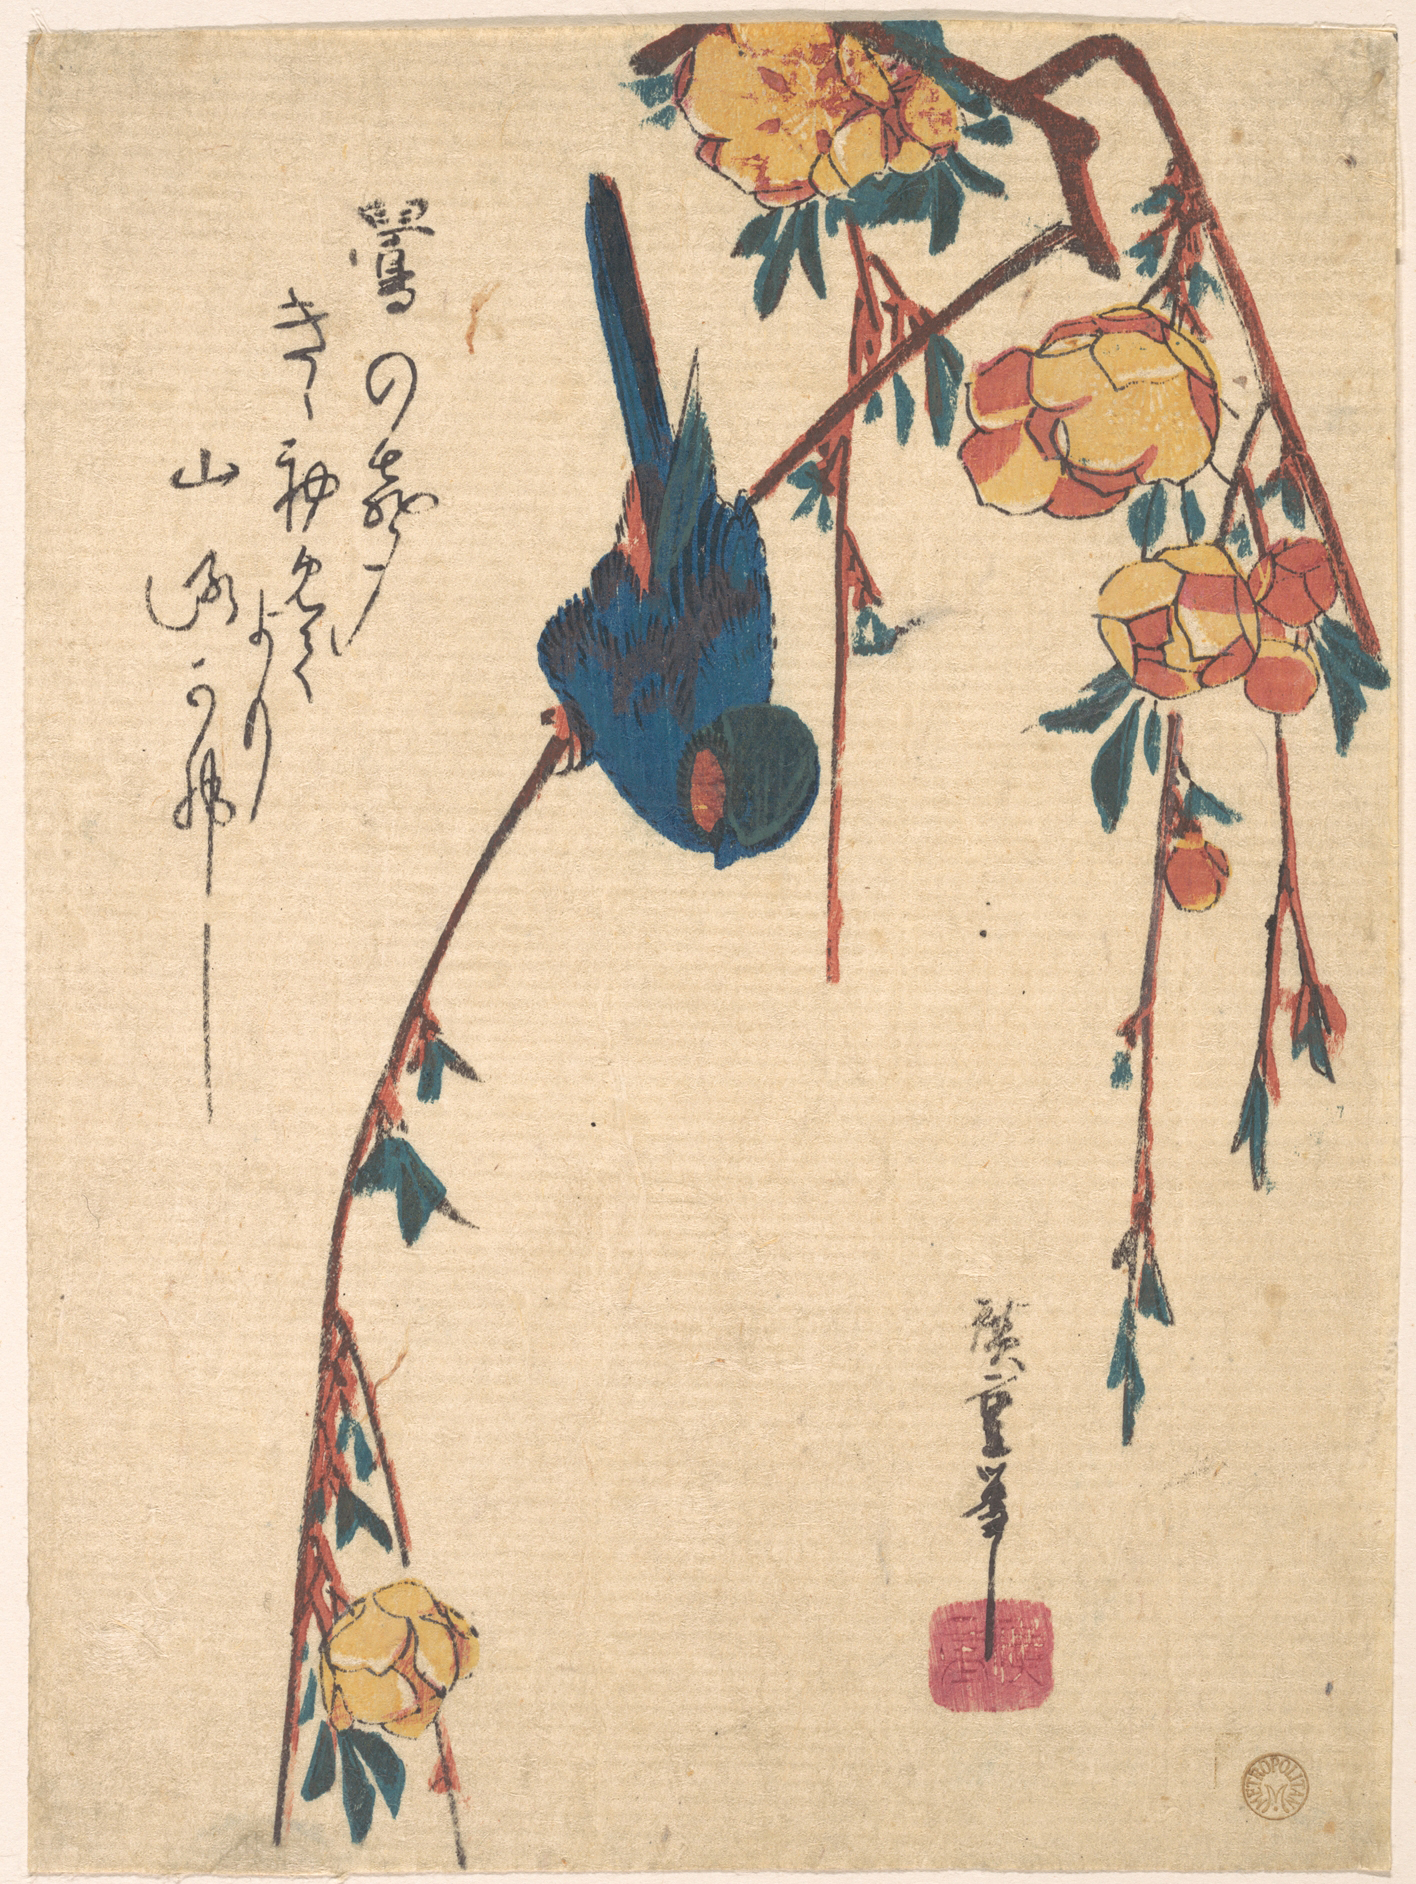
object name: print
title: Weeping Cherry and Bluebird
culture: japanese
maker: utagawa hiroshige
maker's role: artist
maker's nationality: japanese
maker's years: 1797-1858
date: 1838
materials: ink, paper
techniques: woodblock print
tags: birds,flowers,trees